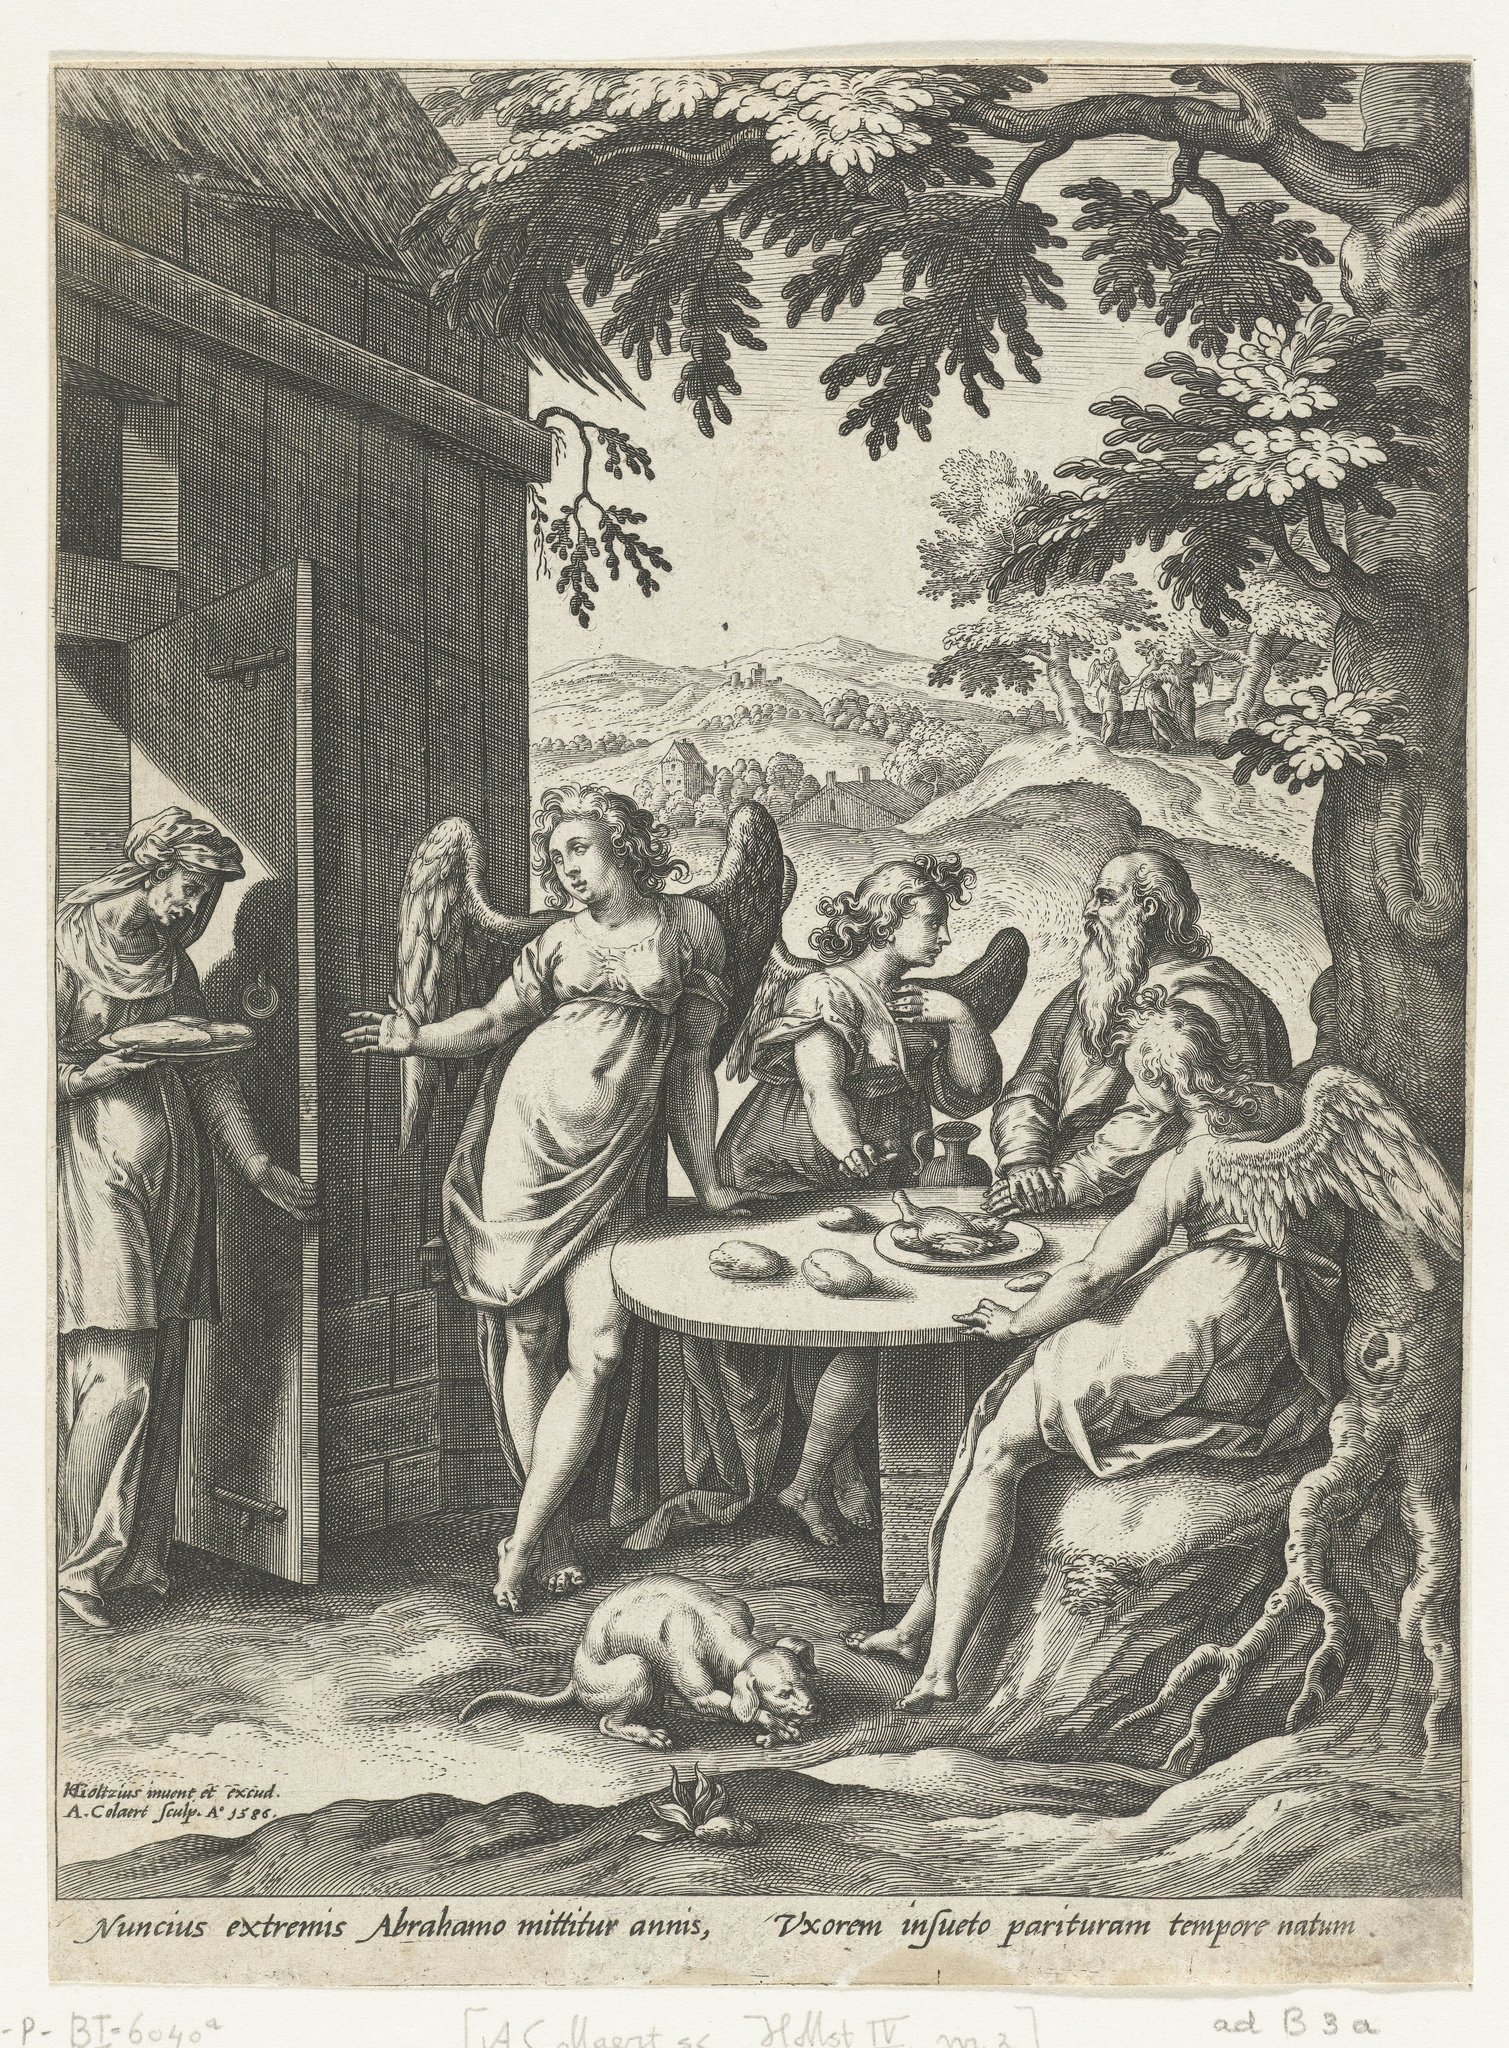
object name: print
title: Aankondiging van de geboorte van Isaak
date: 1586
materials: paper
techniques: engraving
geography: antwerp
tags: the promise of a son is renewed; sarah, overhearing it, laughs incredulously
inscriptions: collector's mark: Lugt 240, signature, date and inscription: ‘HGoltzius inuent et excud./ A. Colaert sculp. A. 1586’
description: Goltzius heeft deze prent ontworpen en uitgegeven. Het vervaardigen van de plaat is echter uitgevoerd door Adriaen Collaert. Serie van zes, alle exemplaren aanwezig in het RPK. Jacobs, G.